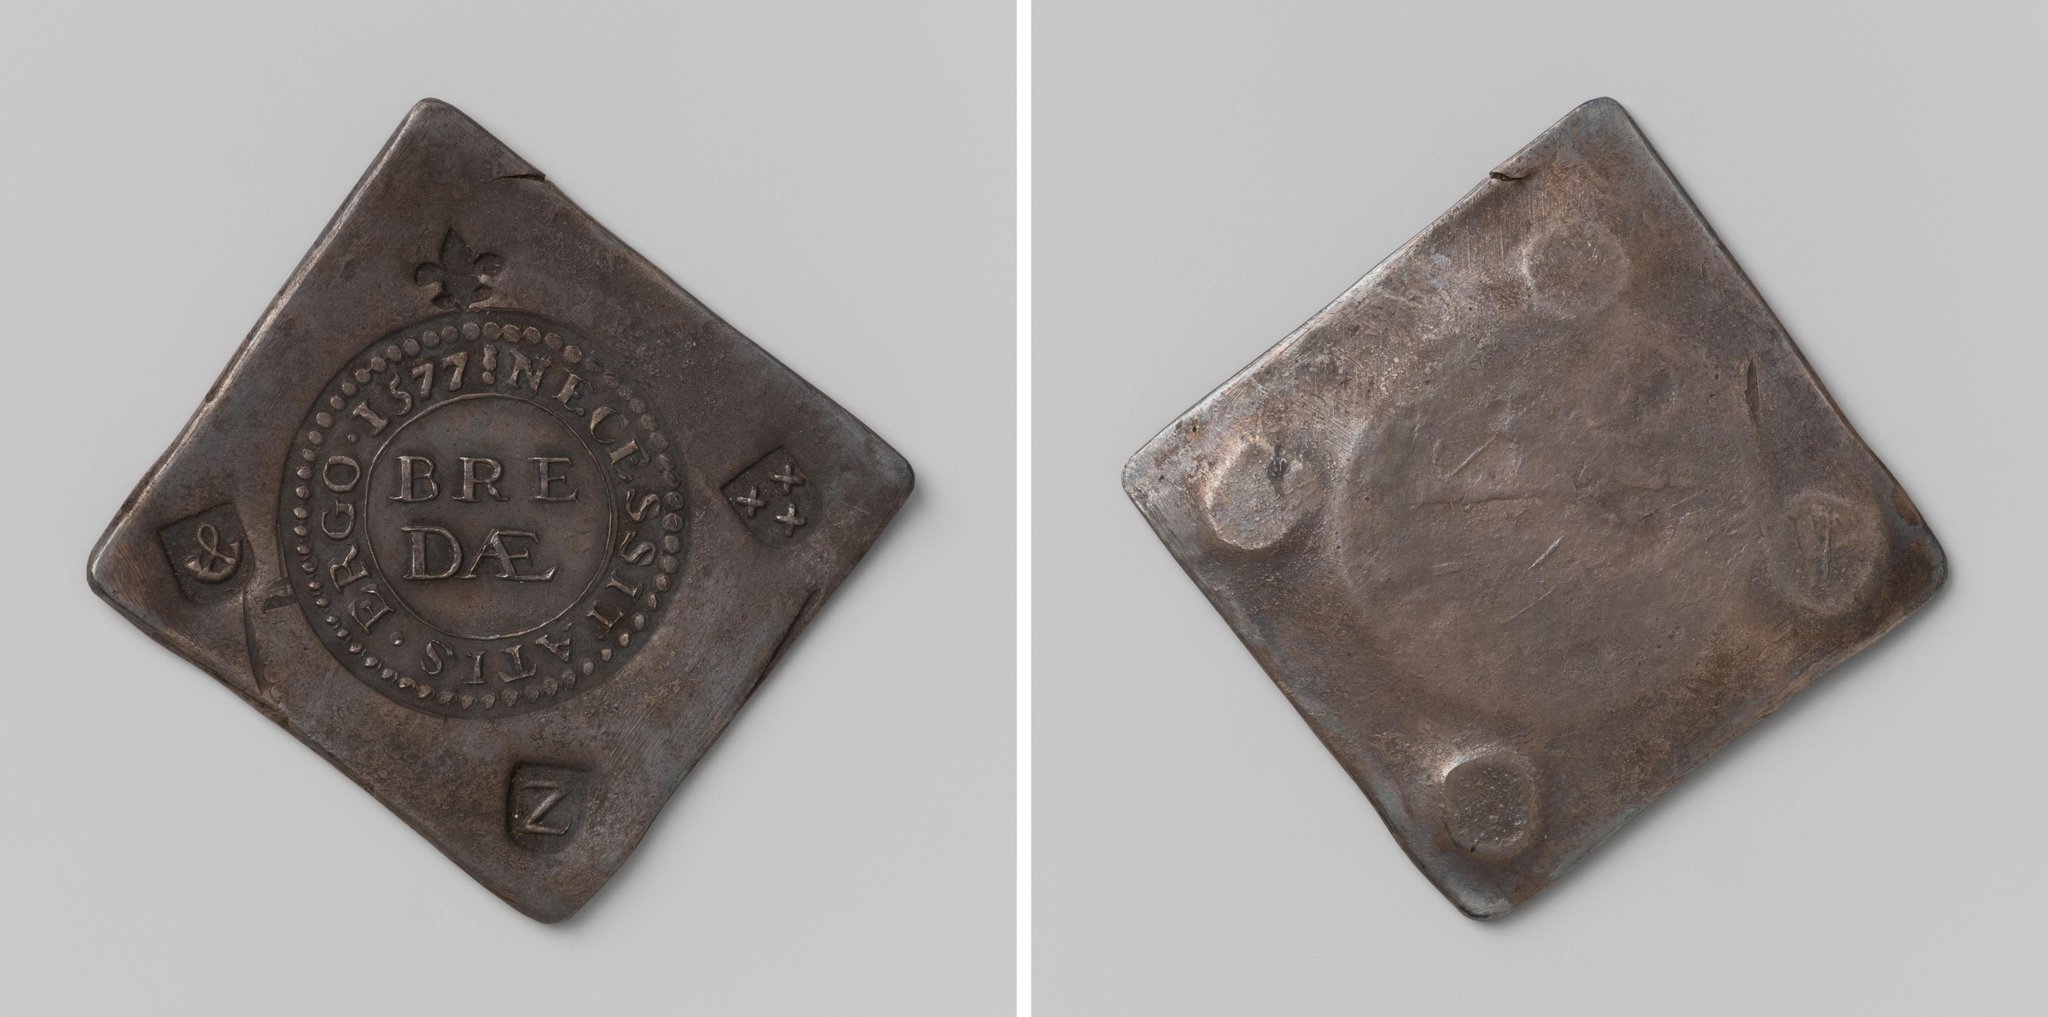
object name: tweegulden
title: Tweegulden (vals), noodmunt uit Breda, kopie van een noodmunt geslagen tijdens het beleg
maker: Anonymous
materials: silver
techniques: striking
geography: netherlands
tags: breda, tachtigjarige oorlog, inname van breda (1577)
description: enkelzijdige, ruitvormige noodmunt van Breda. Voorzijde: vijf stempels: opschrift binnen omschrift en ronde parelrand; daaromheen vier kloppen: boven: lelie, rechts: wapenschild, onder: cijfer 2 en links: hoorntje. Keerzijde: blanco